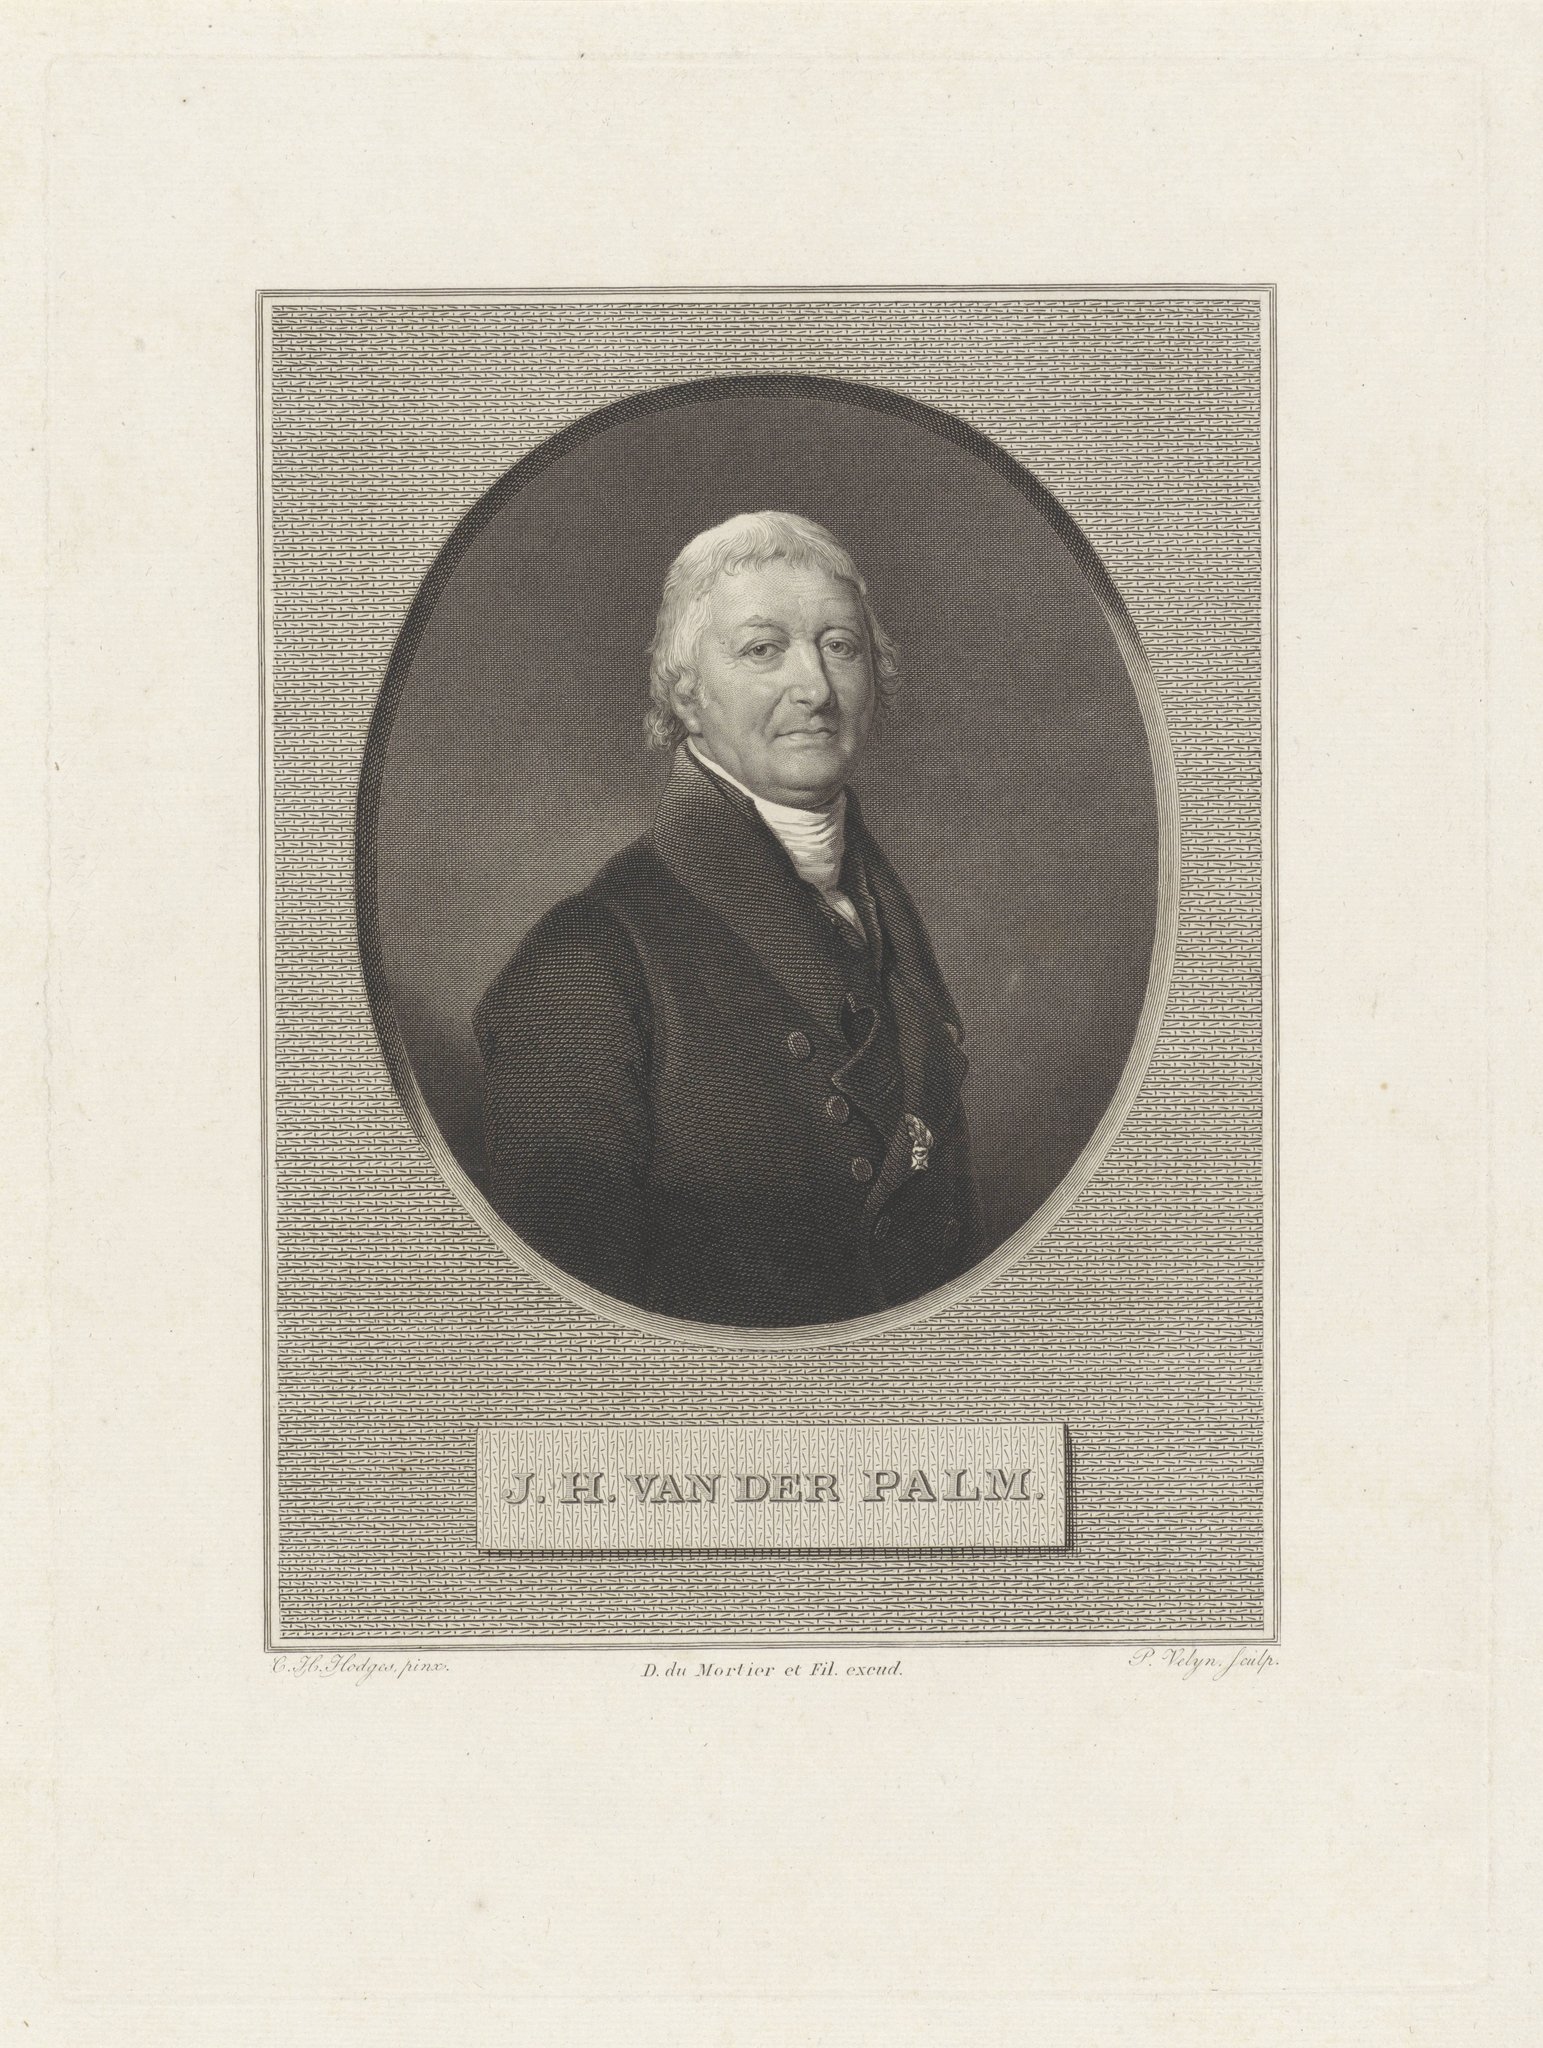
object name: print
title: Portret van Johannes Hendricus van der Palm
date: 1827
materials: paper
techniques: engraving, etching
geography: leiden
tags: rotterdam, leiden, johannes hendricus van der palm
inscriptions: collector's mark: Lugt 2228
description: Portret van Johannes Hendricus van der Palm, predikant en Minister van Onderwijs.